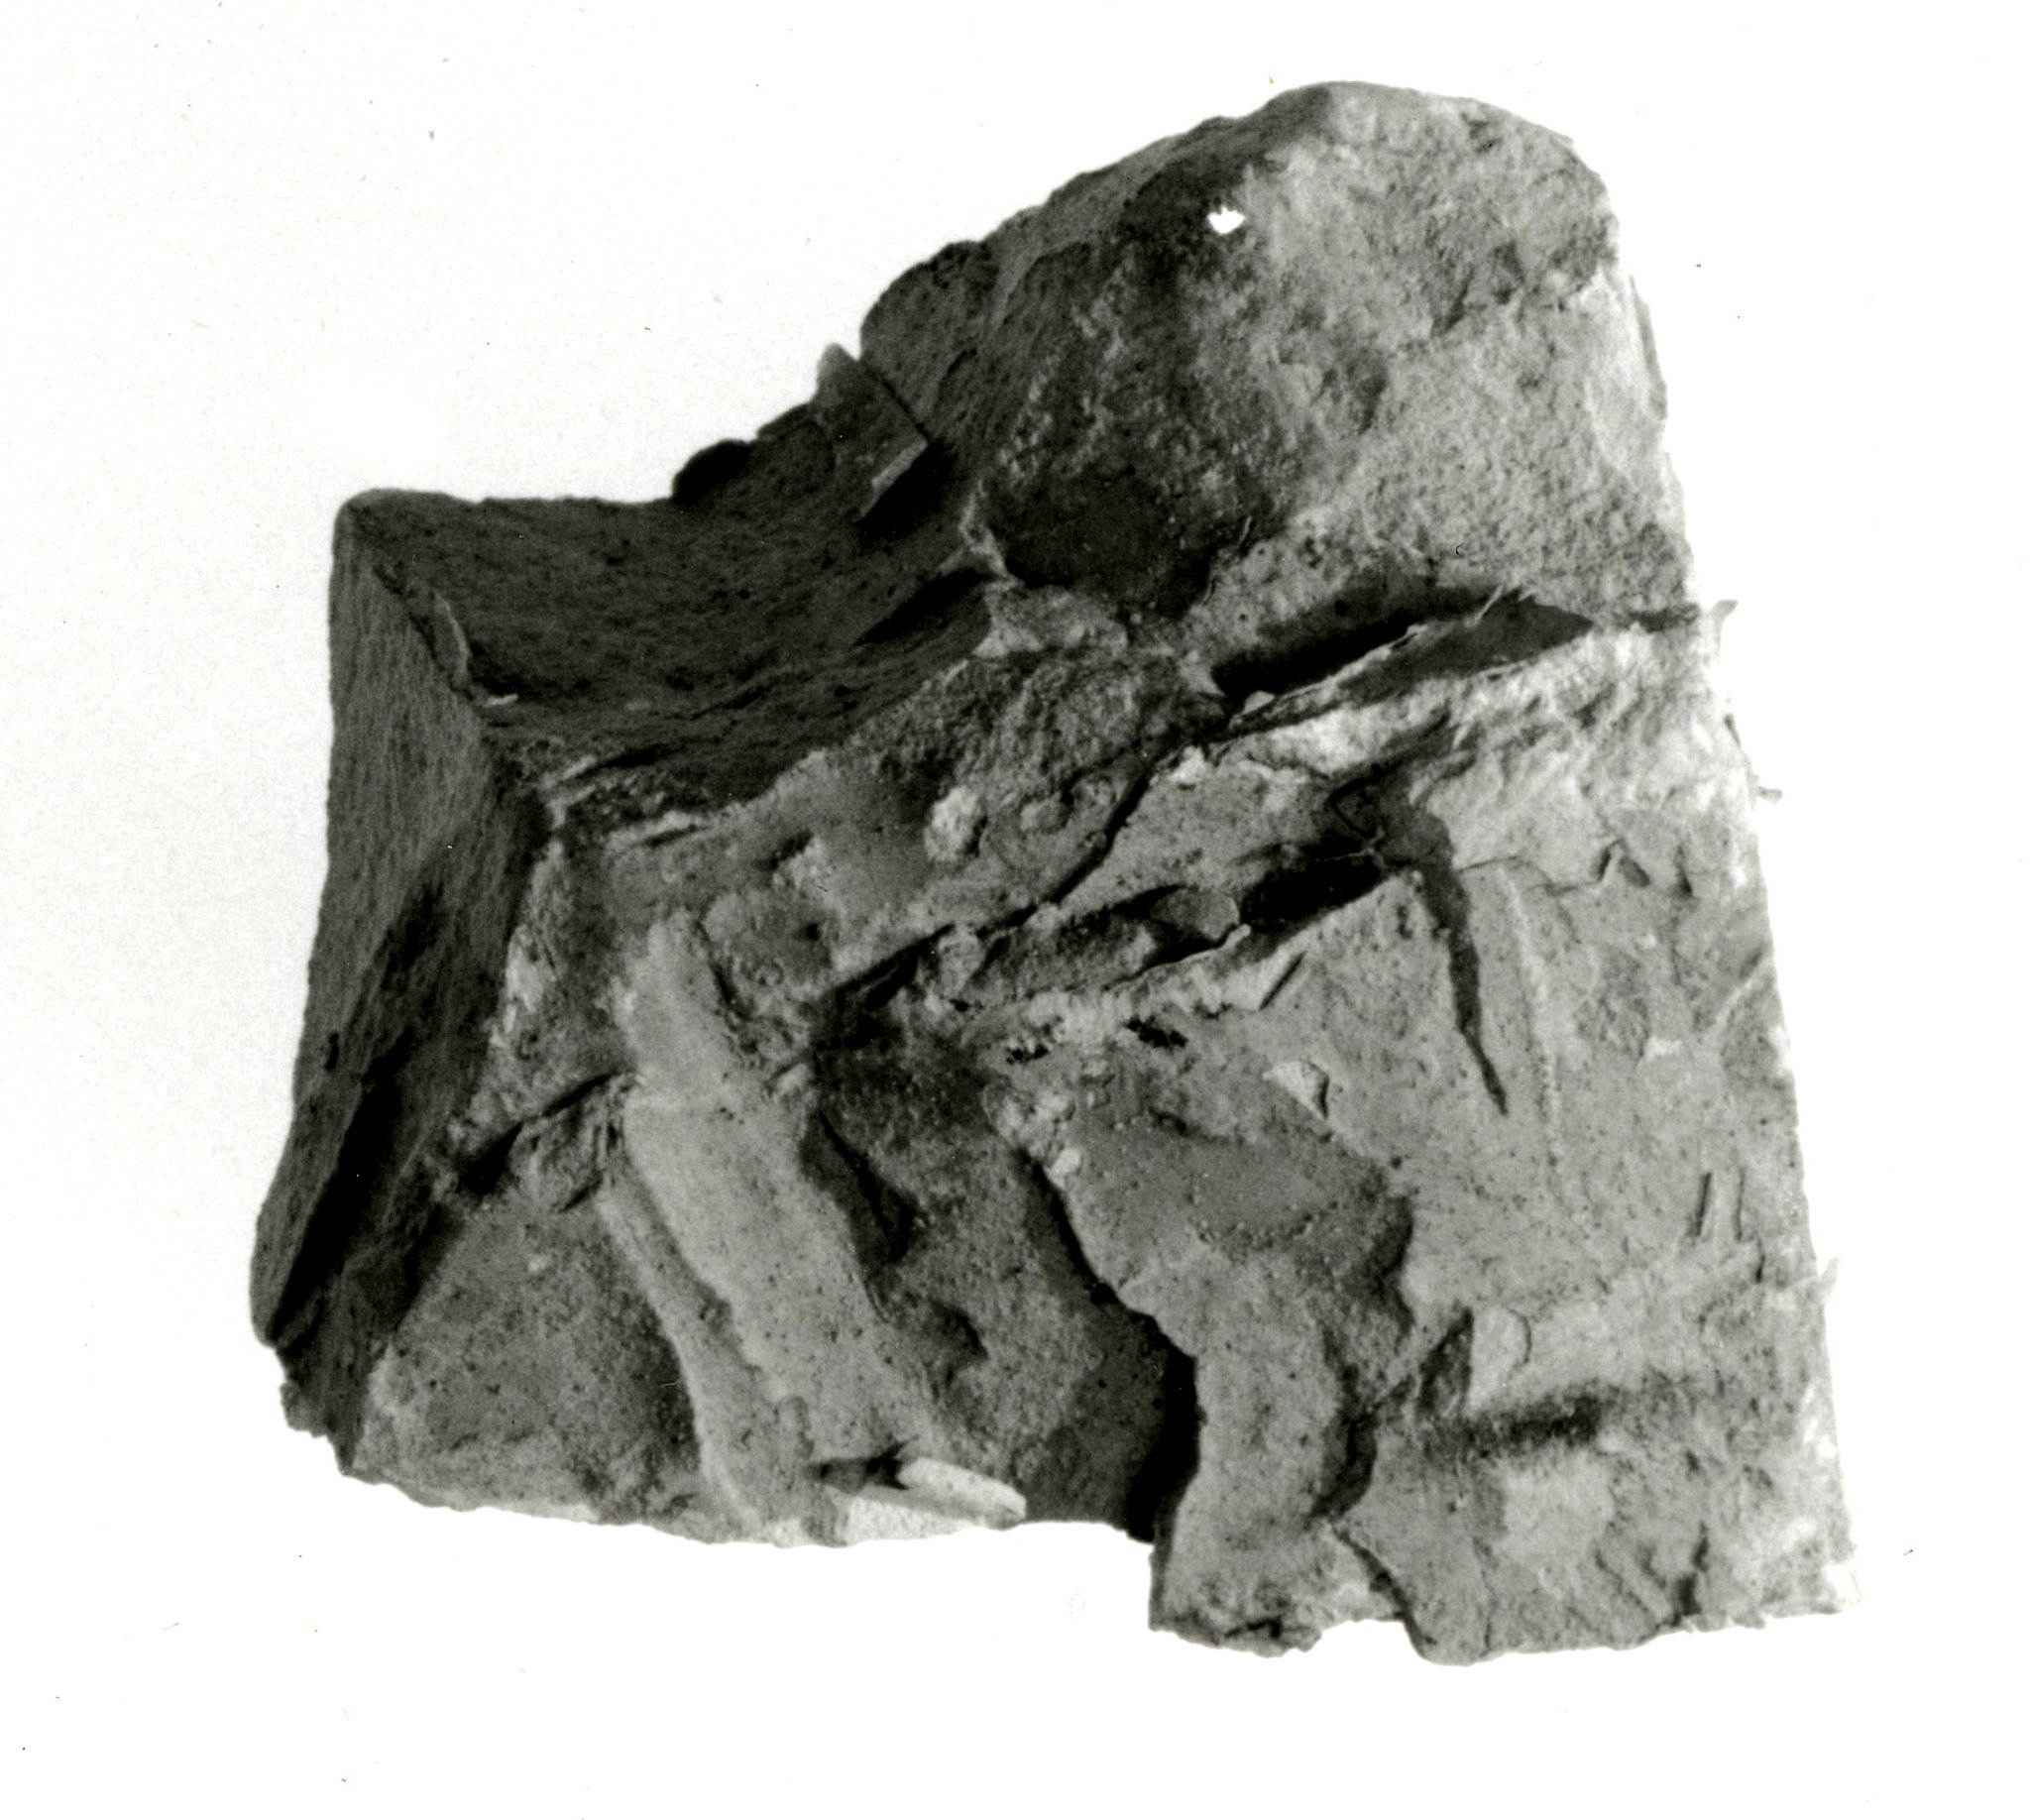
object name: relief, tomb of nespekashuty, wall casing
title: Wall casing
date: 664-610 BCE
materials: limestone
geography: egypt